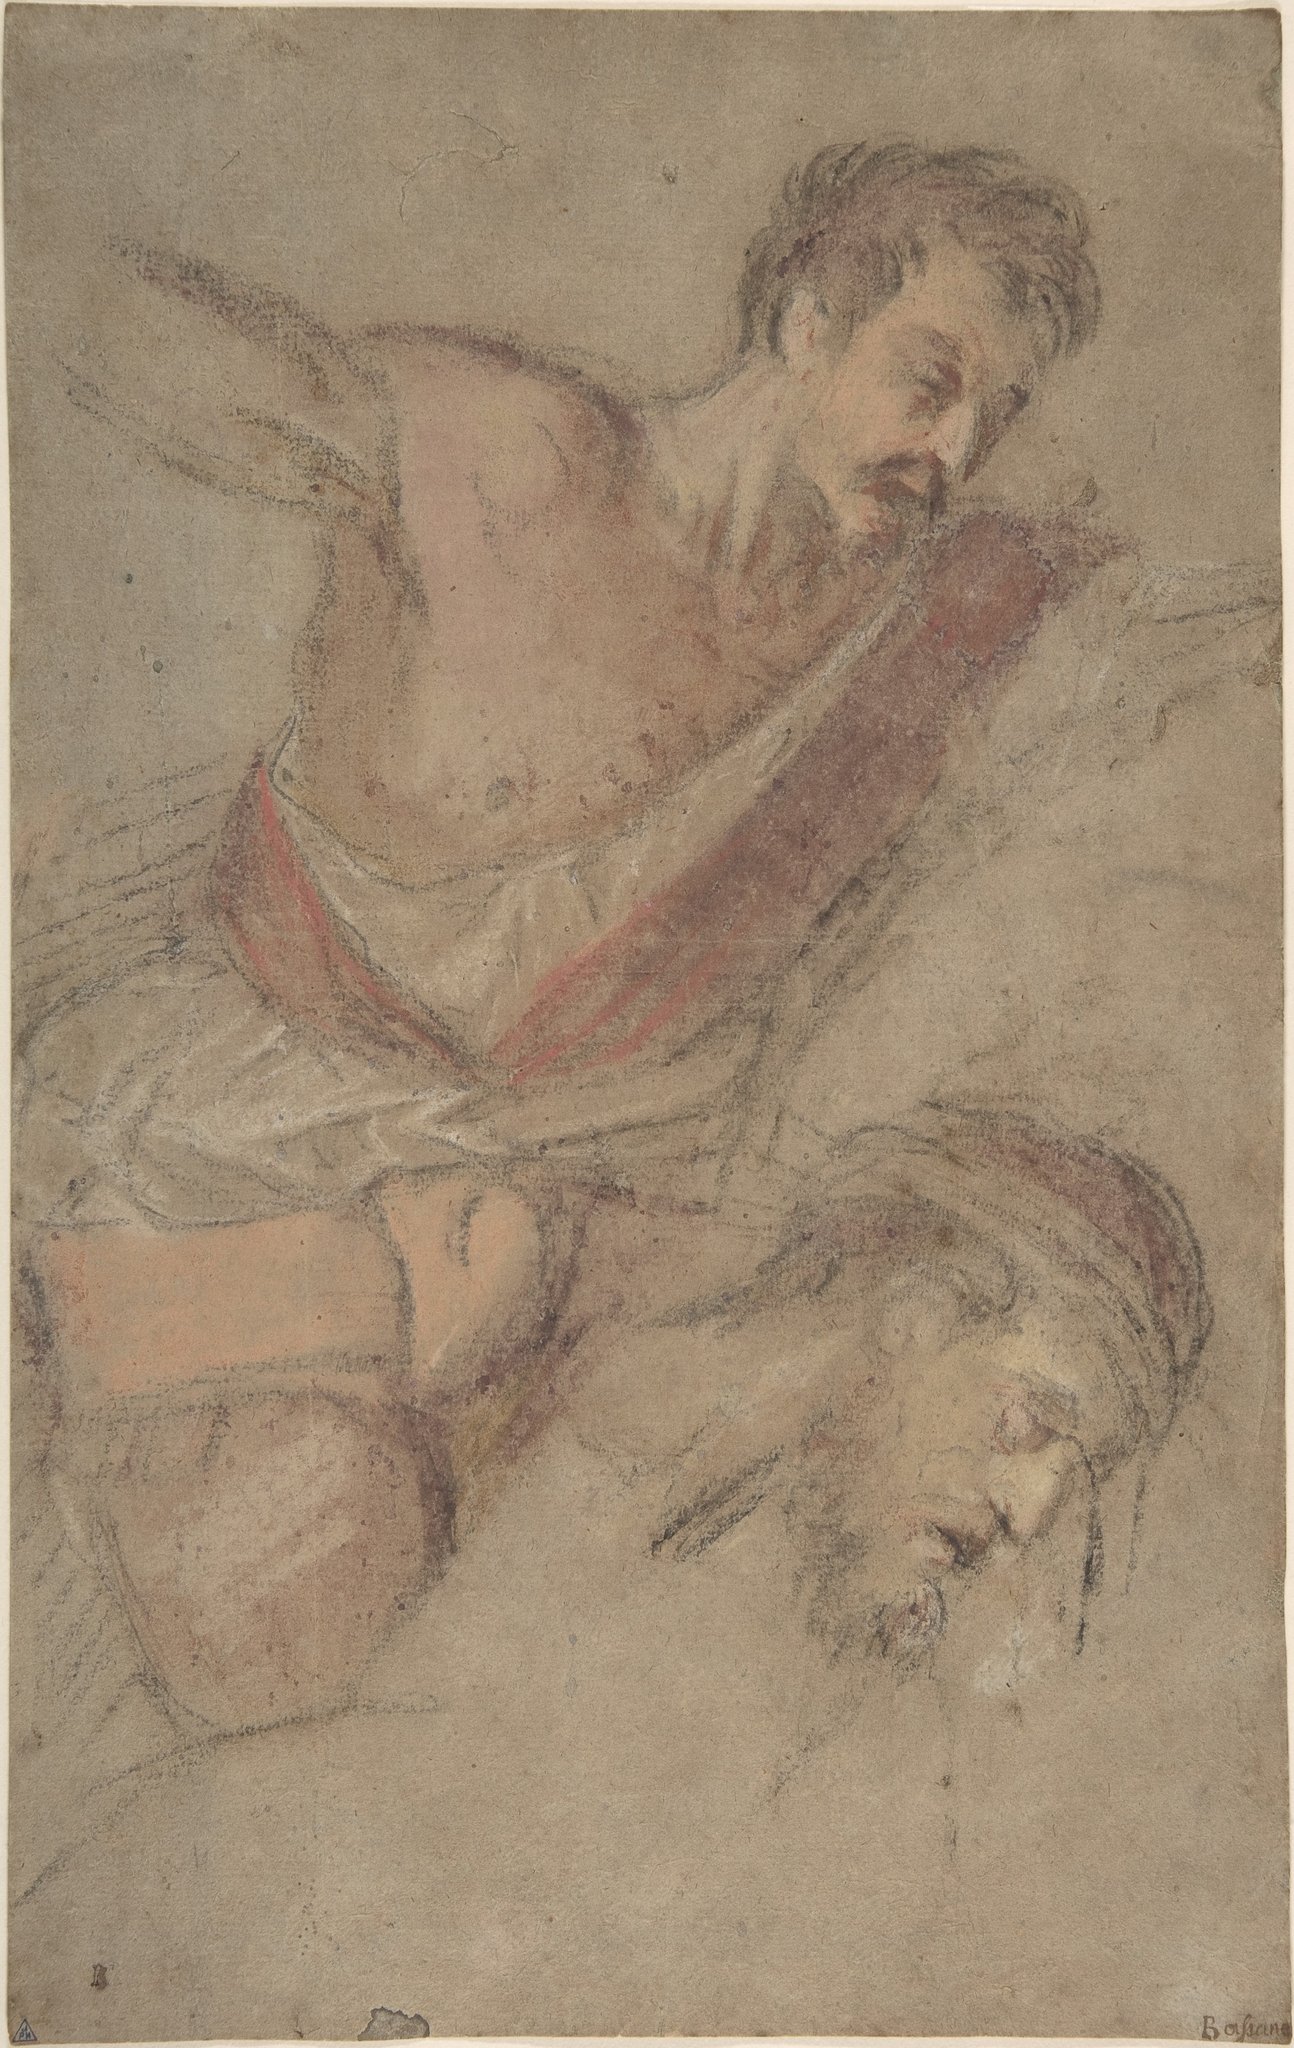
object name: drawing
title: Studies for a Scourging Soldier and the Head of Christ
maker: jacopo bassano (jacopo da ponte)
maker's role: artist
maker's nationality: italian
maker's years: 1510-1592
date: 1565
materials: chalk, paper, pastel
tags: soldiers,men,christ